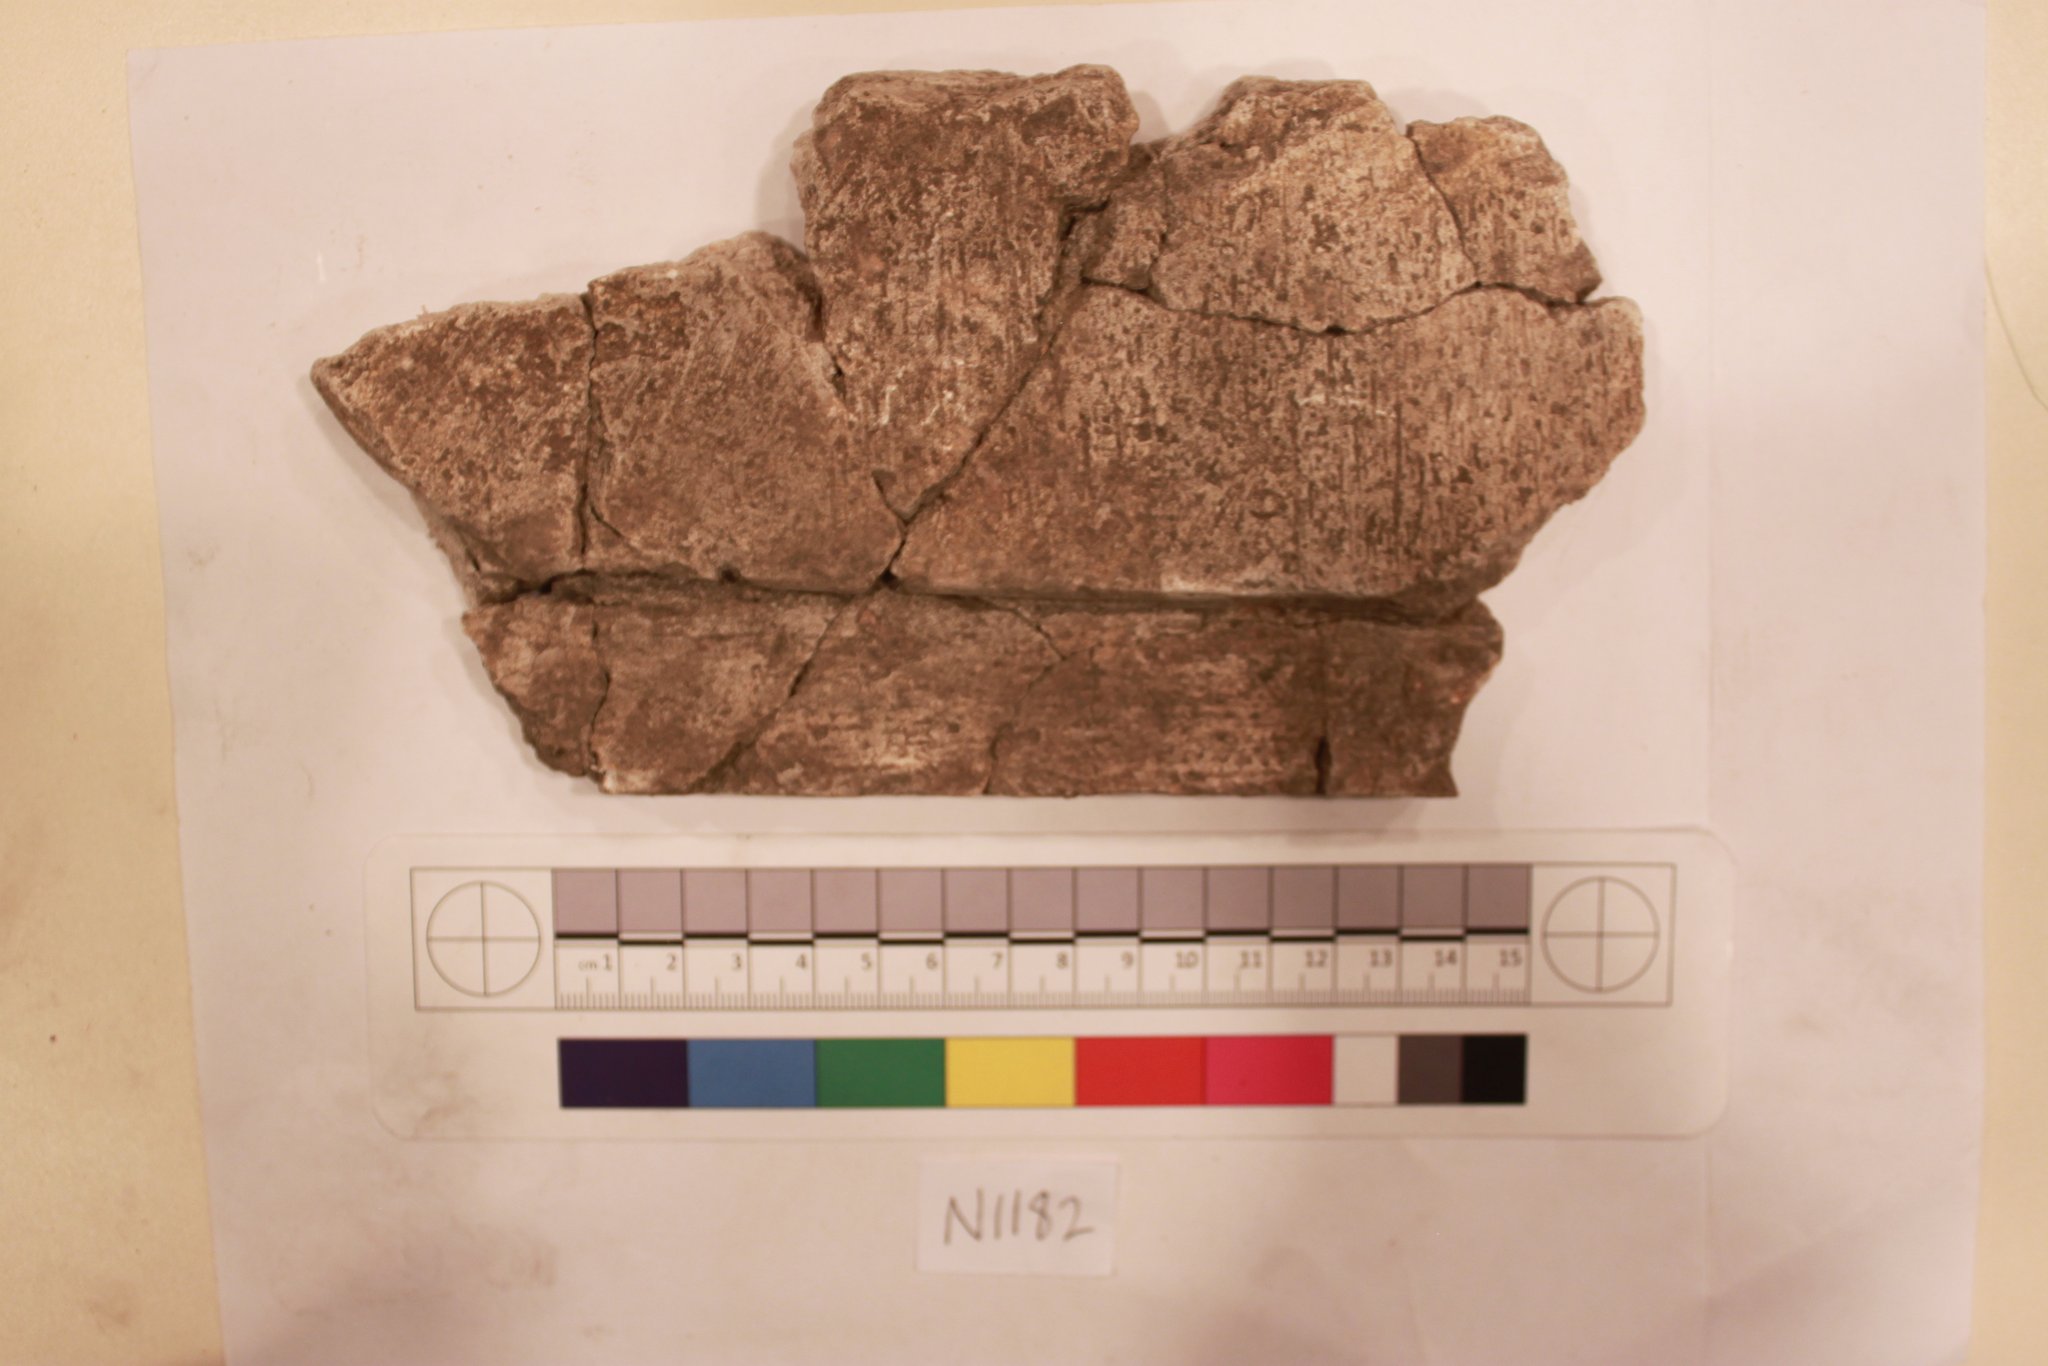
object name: fragment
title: Stucco Fragment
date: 701-1200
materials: plaster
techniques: carving, painting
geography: iran